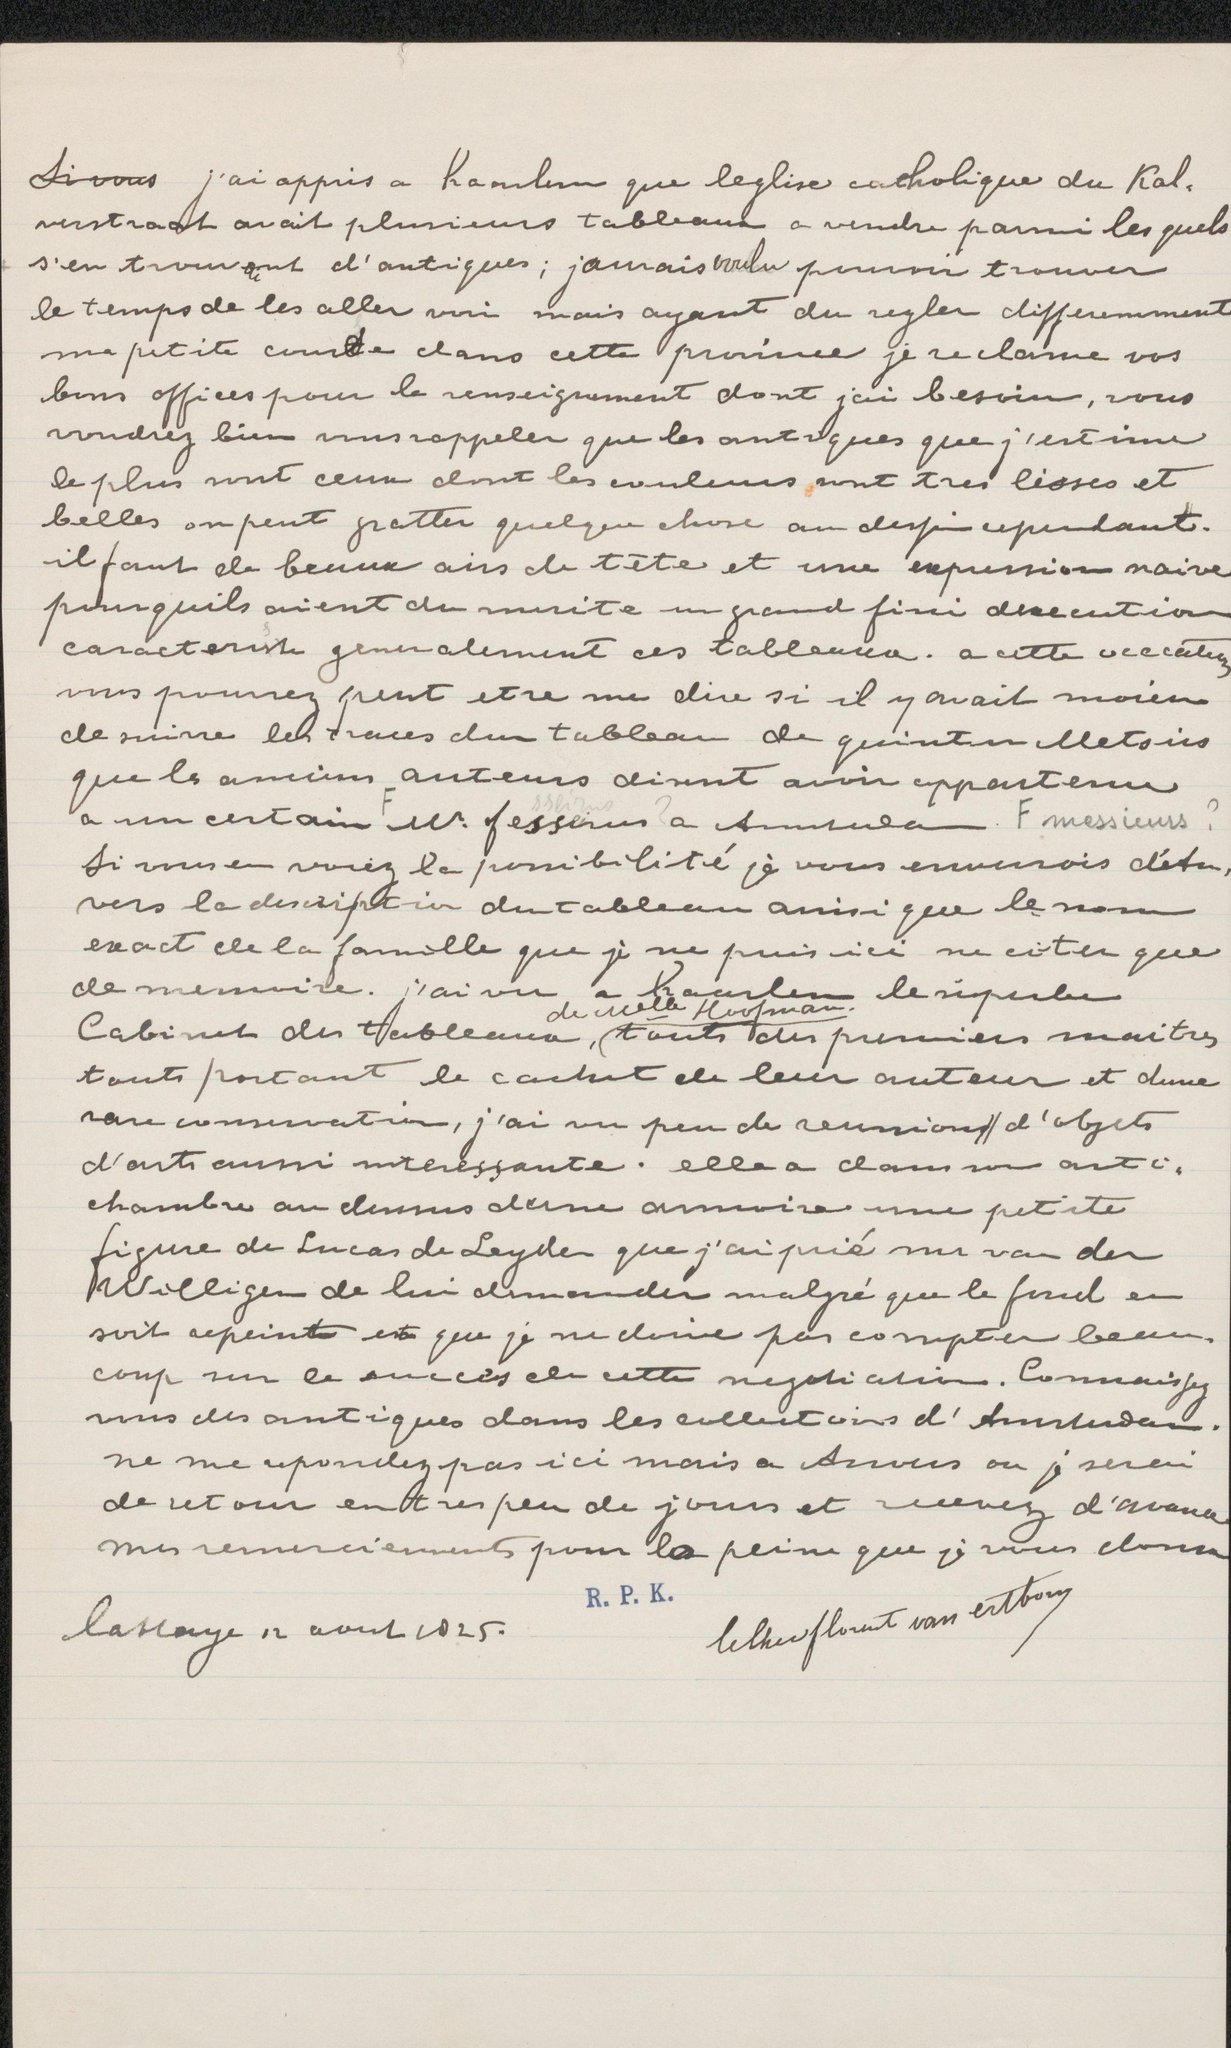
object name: letter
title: Brief aan anoniem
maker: florent van ertborn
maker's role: kunstverzamelaar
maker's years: 1784-1840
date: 1794-1840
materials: ink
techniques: pen, writing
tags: lucas van leyden, rotterdam, adriaan van der willigen, art trade, art shop, painting (including book-illumination, miniature-painting), haarlem, antwerp, amsterdam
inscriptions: collector's mark: Lugt 2233